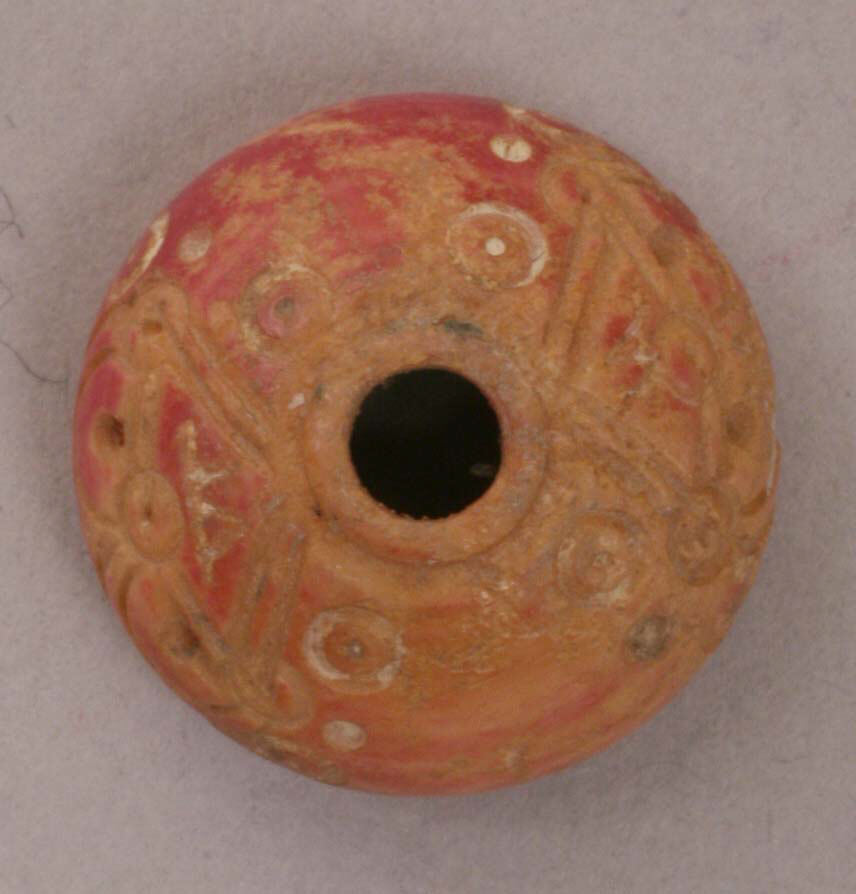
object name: button or bead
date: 801-1000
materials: bone, paint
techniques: incising, inlay, tinting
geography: iran